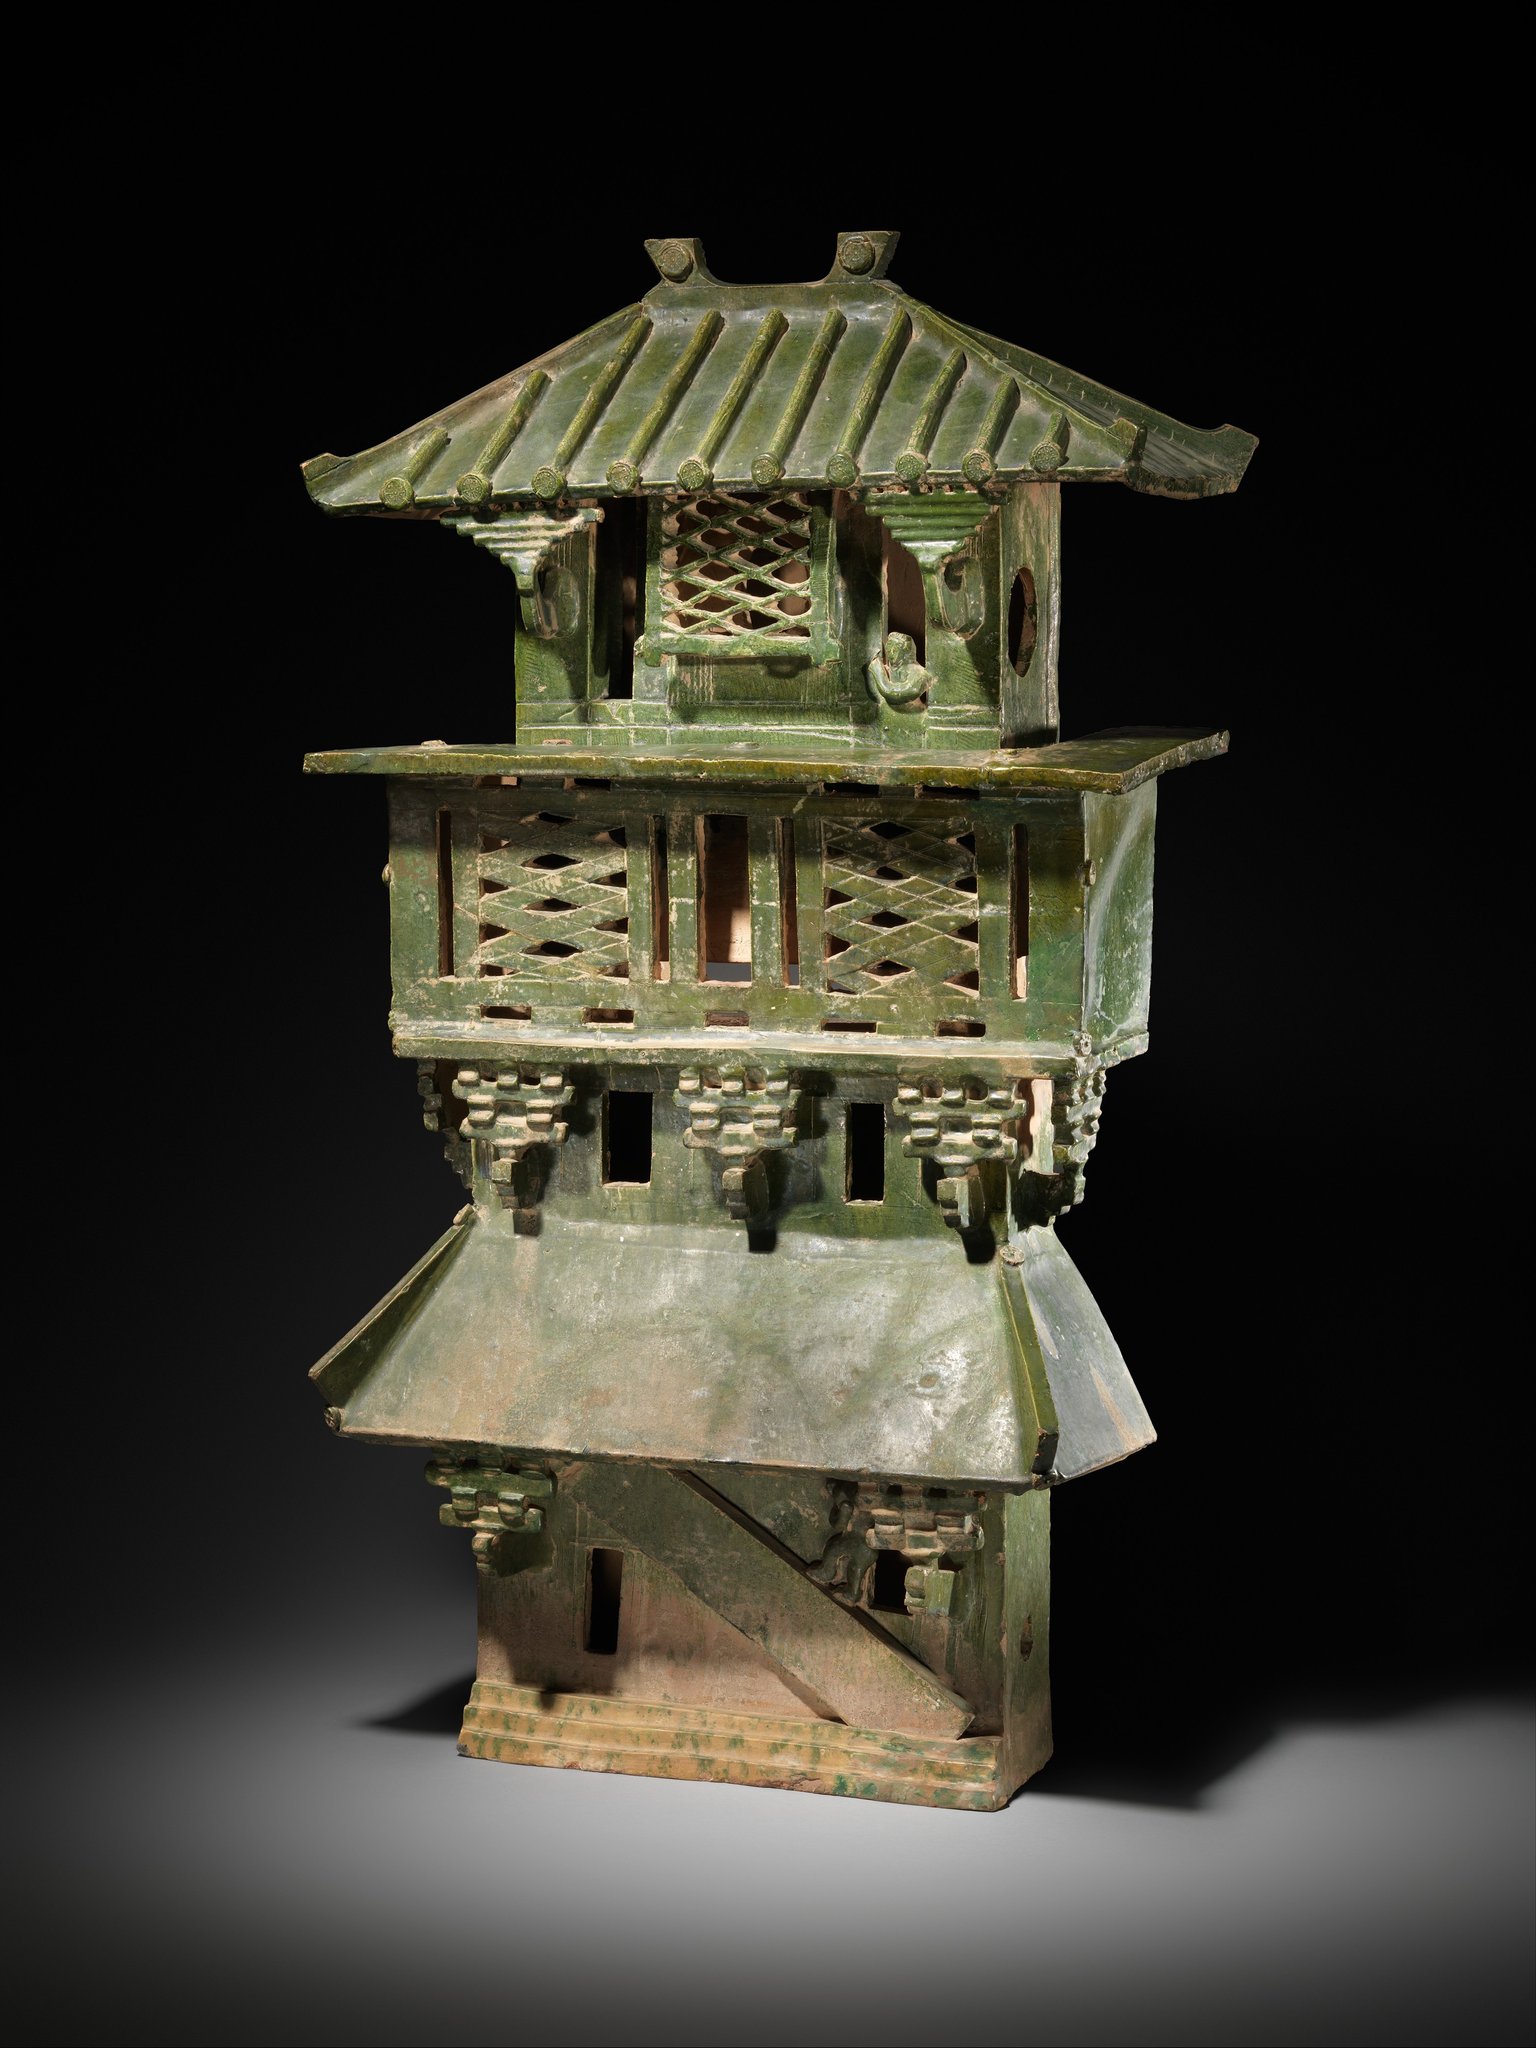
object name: architectural model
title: Central Watchtower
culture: chinese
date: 1-233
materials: earthenware, glaze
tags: towers